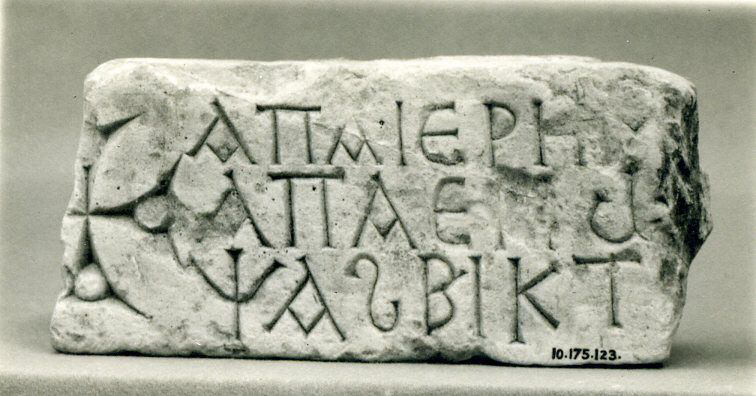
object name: fragment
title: Fragment of an Inscribed Block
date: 501-700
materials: limestone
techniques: incising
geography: egypt